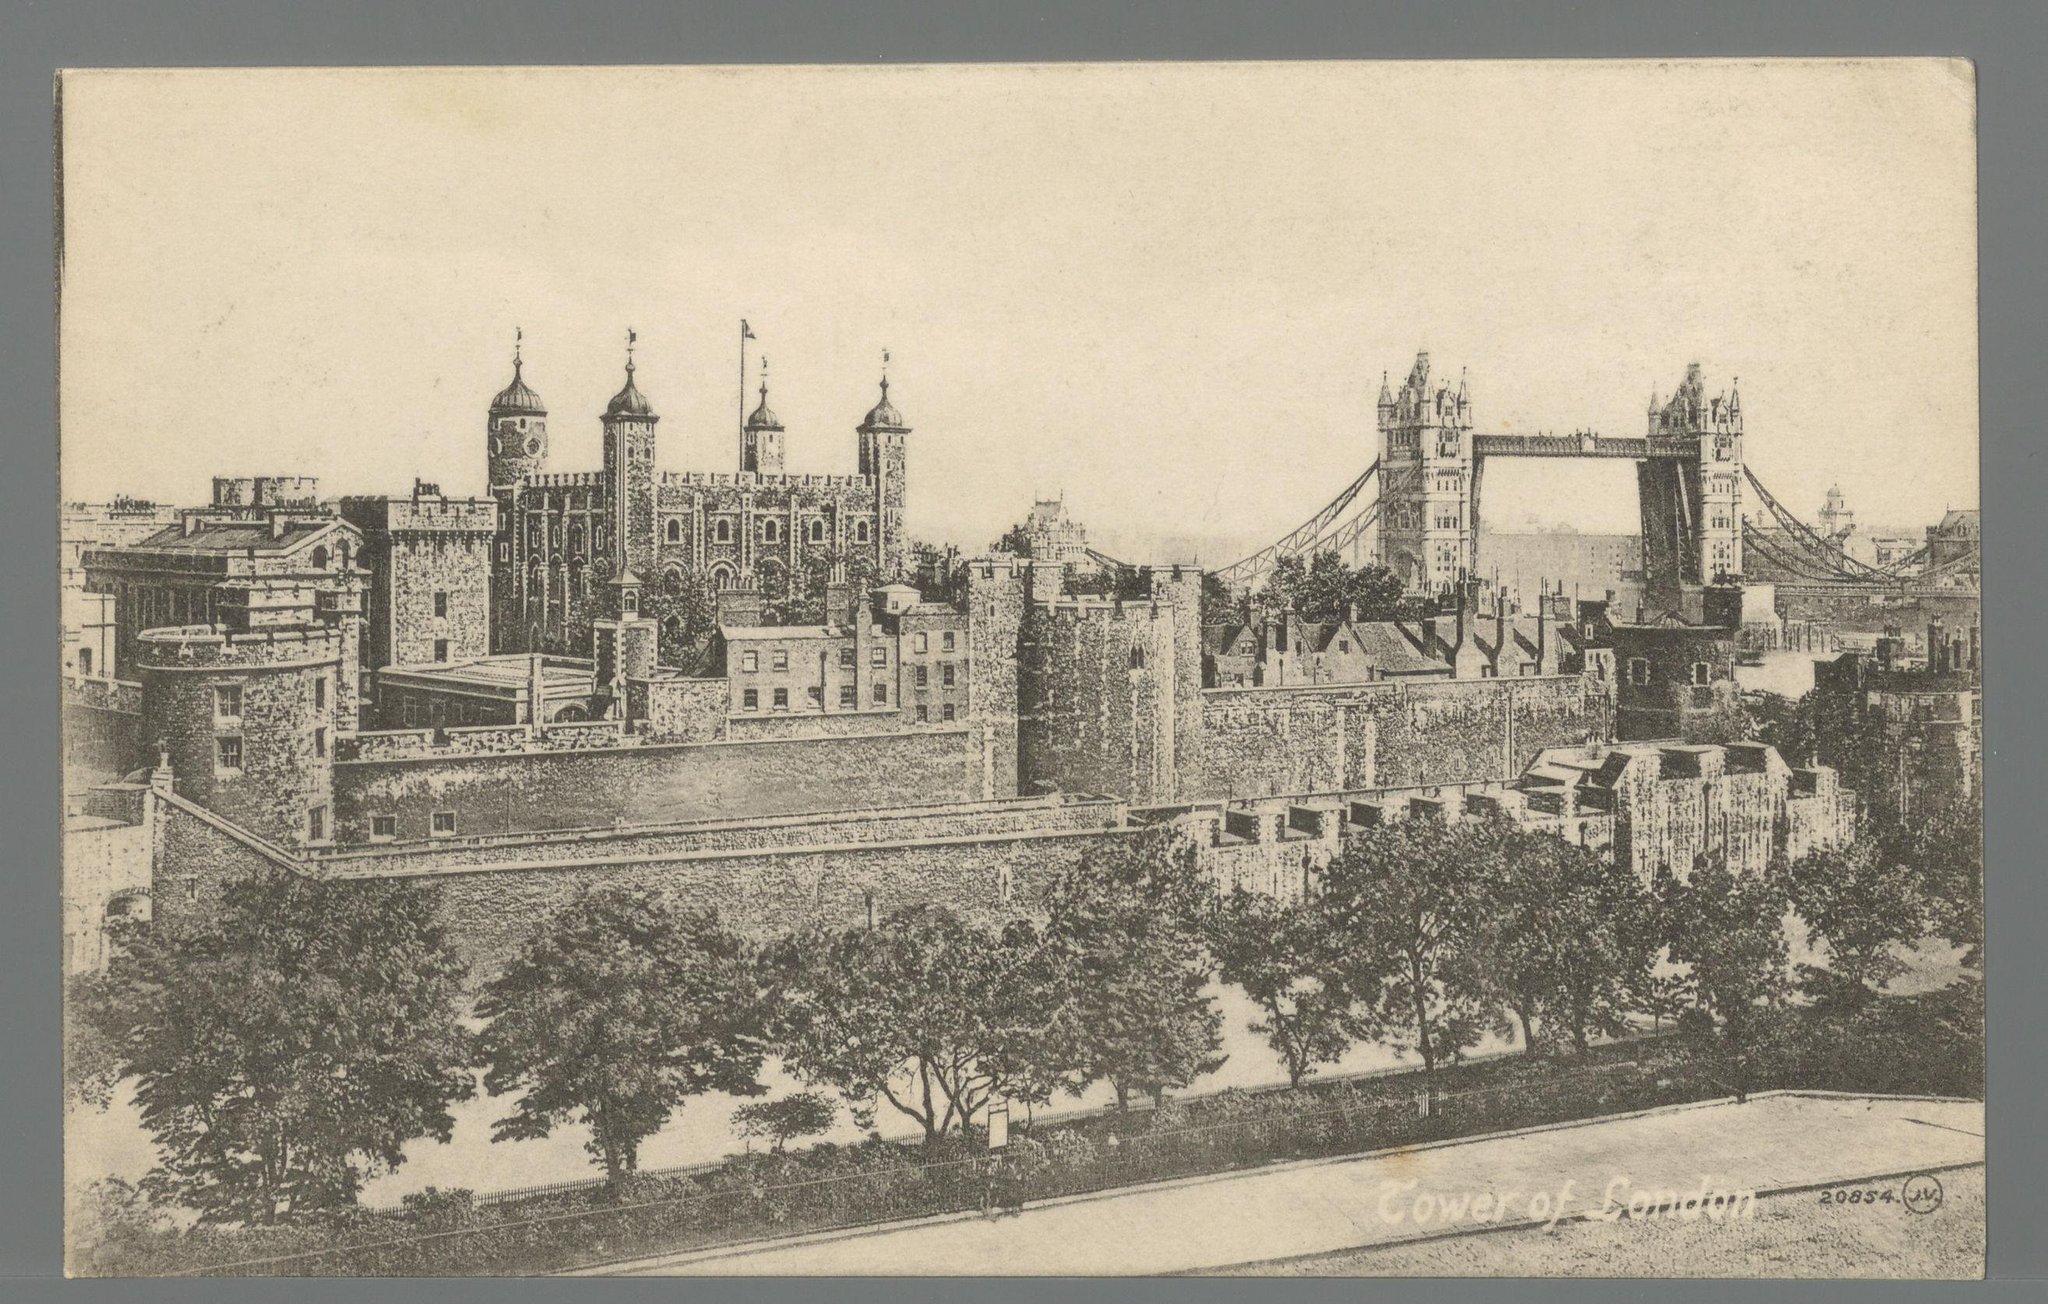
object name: photomechanical print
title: Tower of London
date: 1902-1930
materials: cardboard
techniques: photograph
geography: great britain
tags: castle, bridge in village across river, canal, etc.